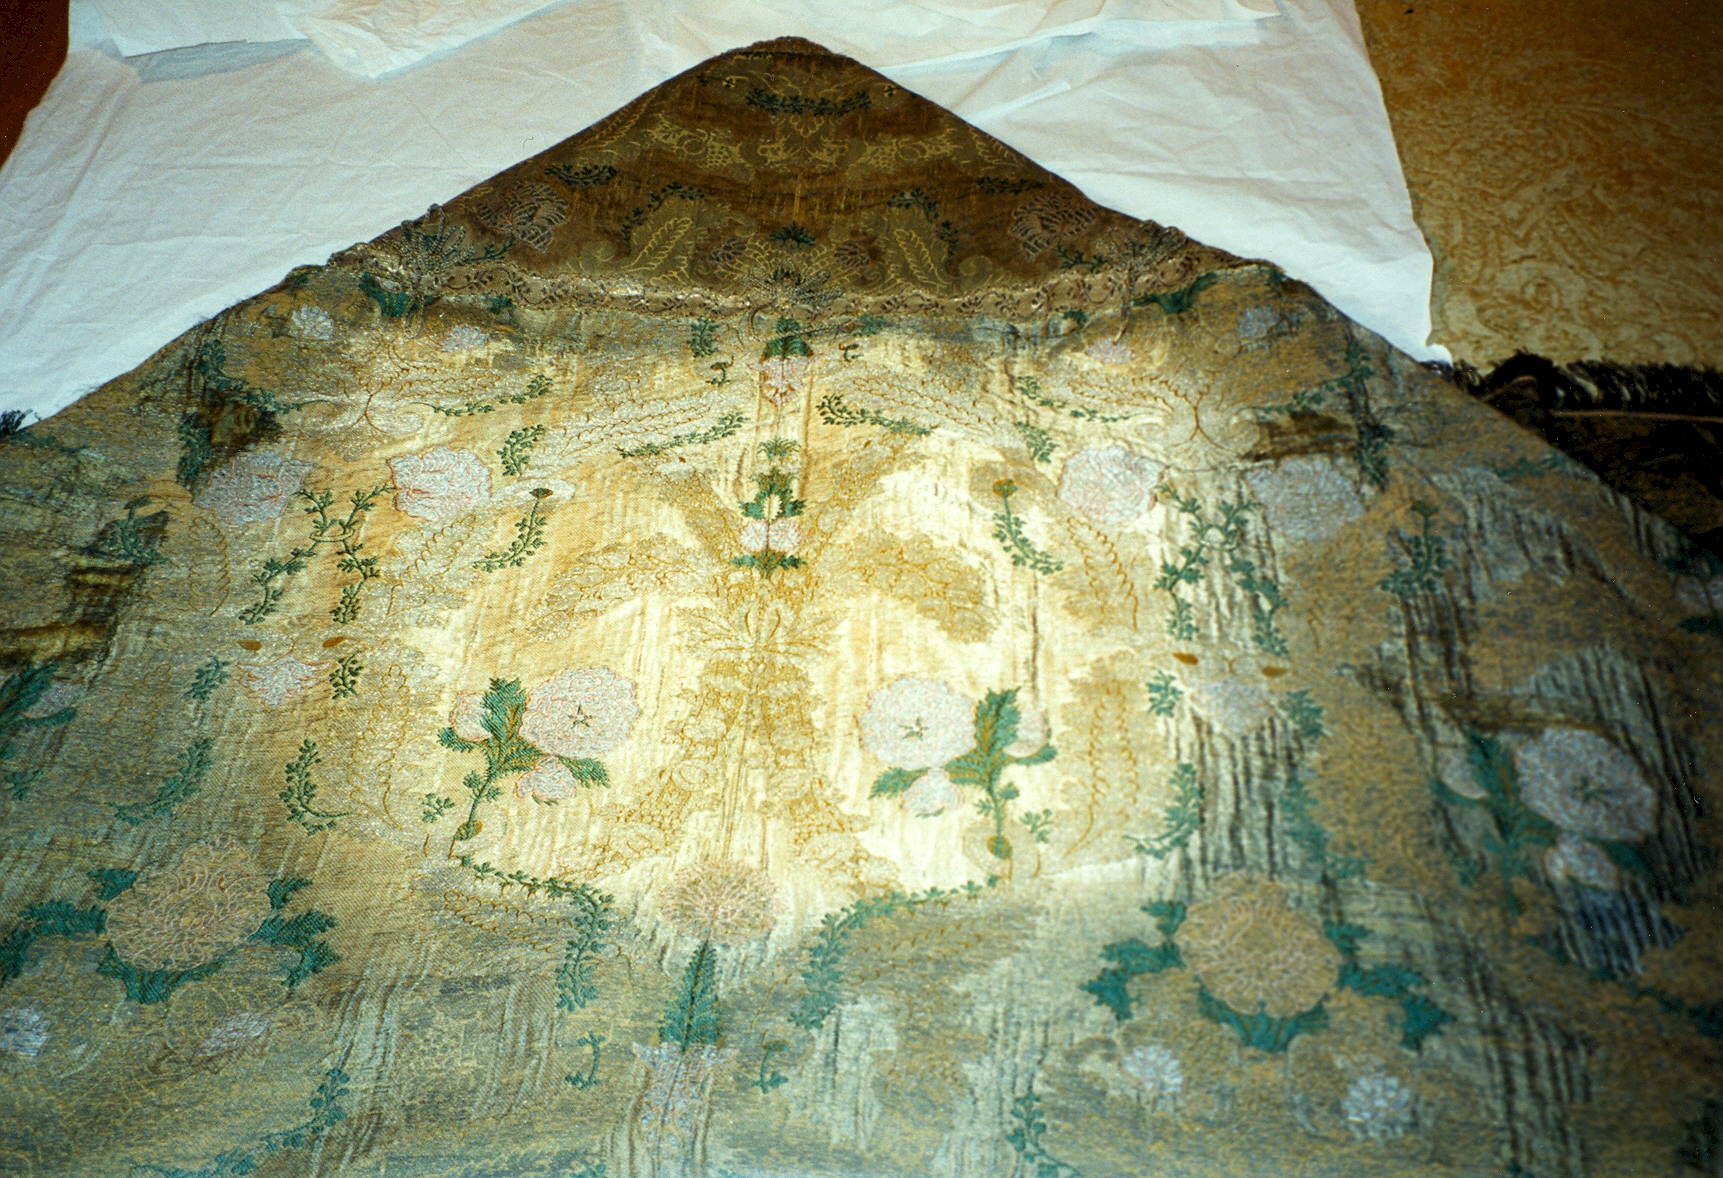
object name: hood from a cope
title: Cope and Hood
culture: russian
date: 1801-1900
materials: metal, silk